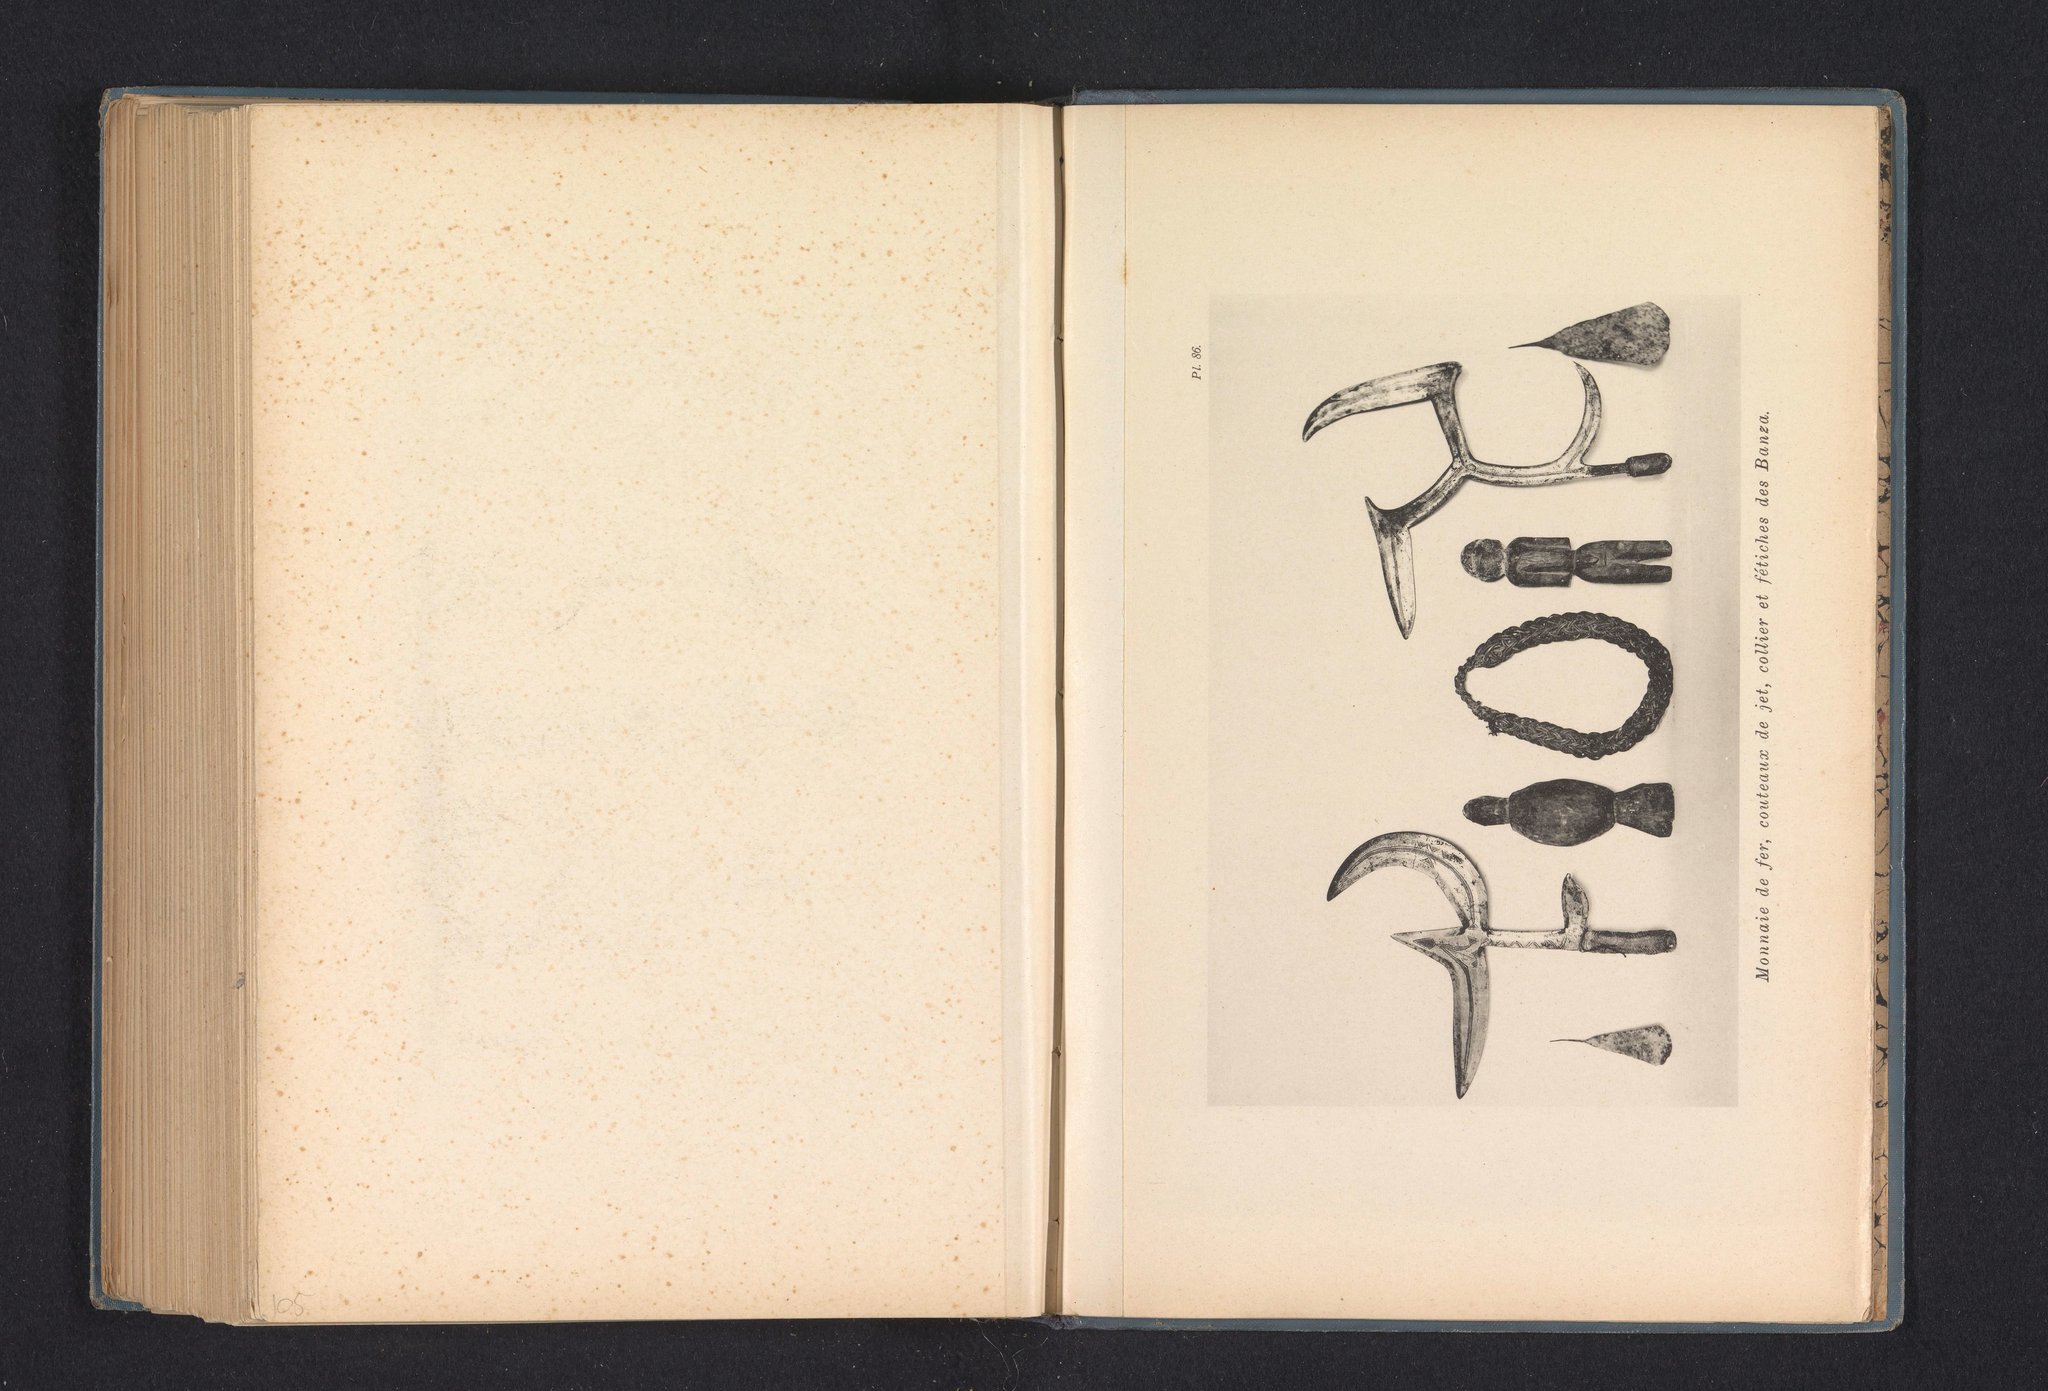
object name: page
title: Geld, werpmessen, een halsketting en religieuze beelden van de Banza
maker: franz thonner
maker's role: botanicus, ontdekkingsreiziger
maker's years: 1863-1928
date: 1896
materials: paper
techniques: photograph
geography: dresden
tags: sculpture, necklace, tools, aids, implements ~ crafts and industries: knife, money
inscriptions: number: ‘Pl. 86.’